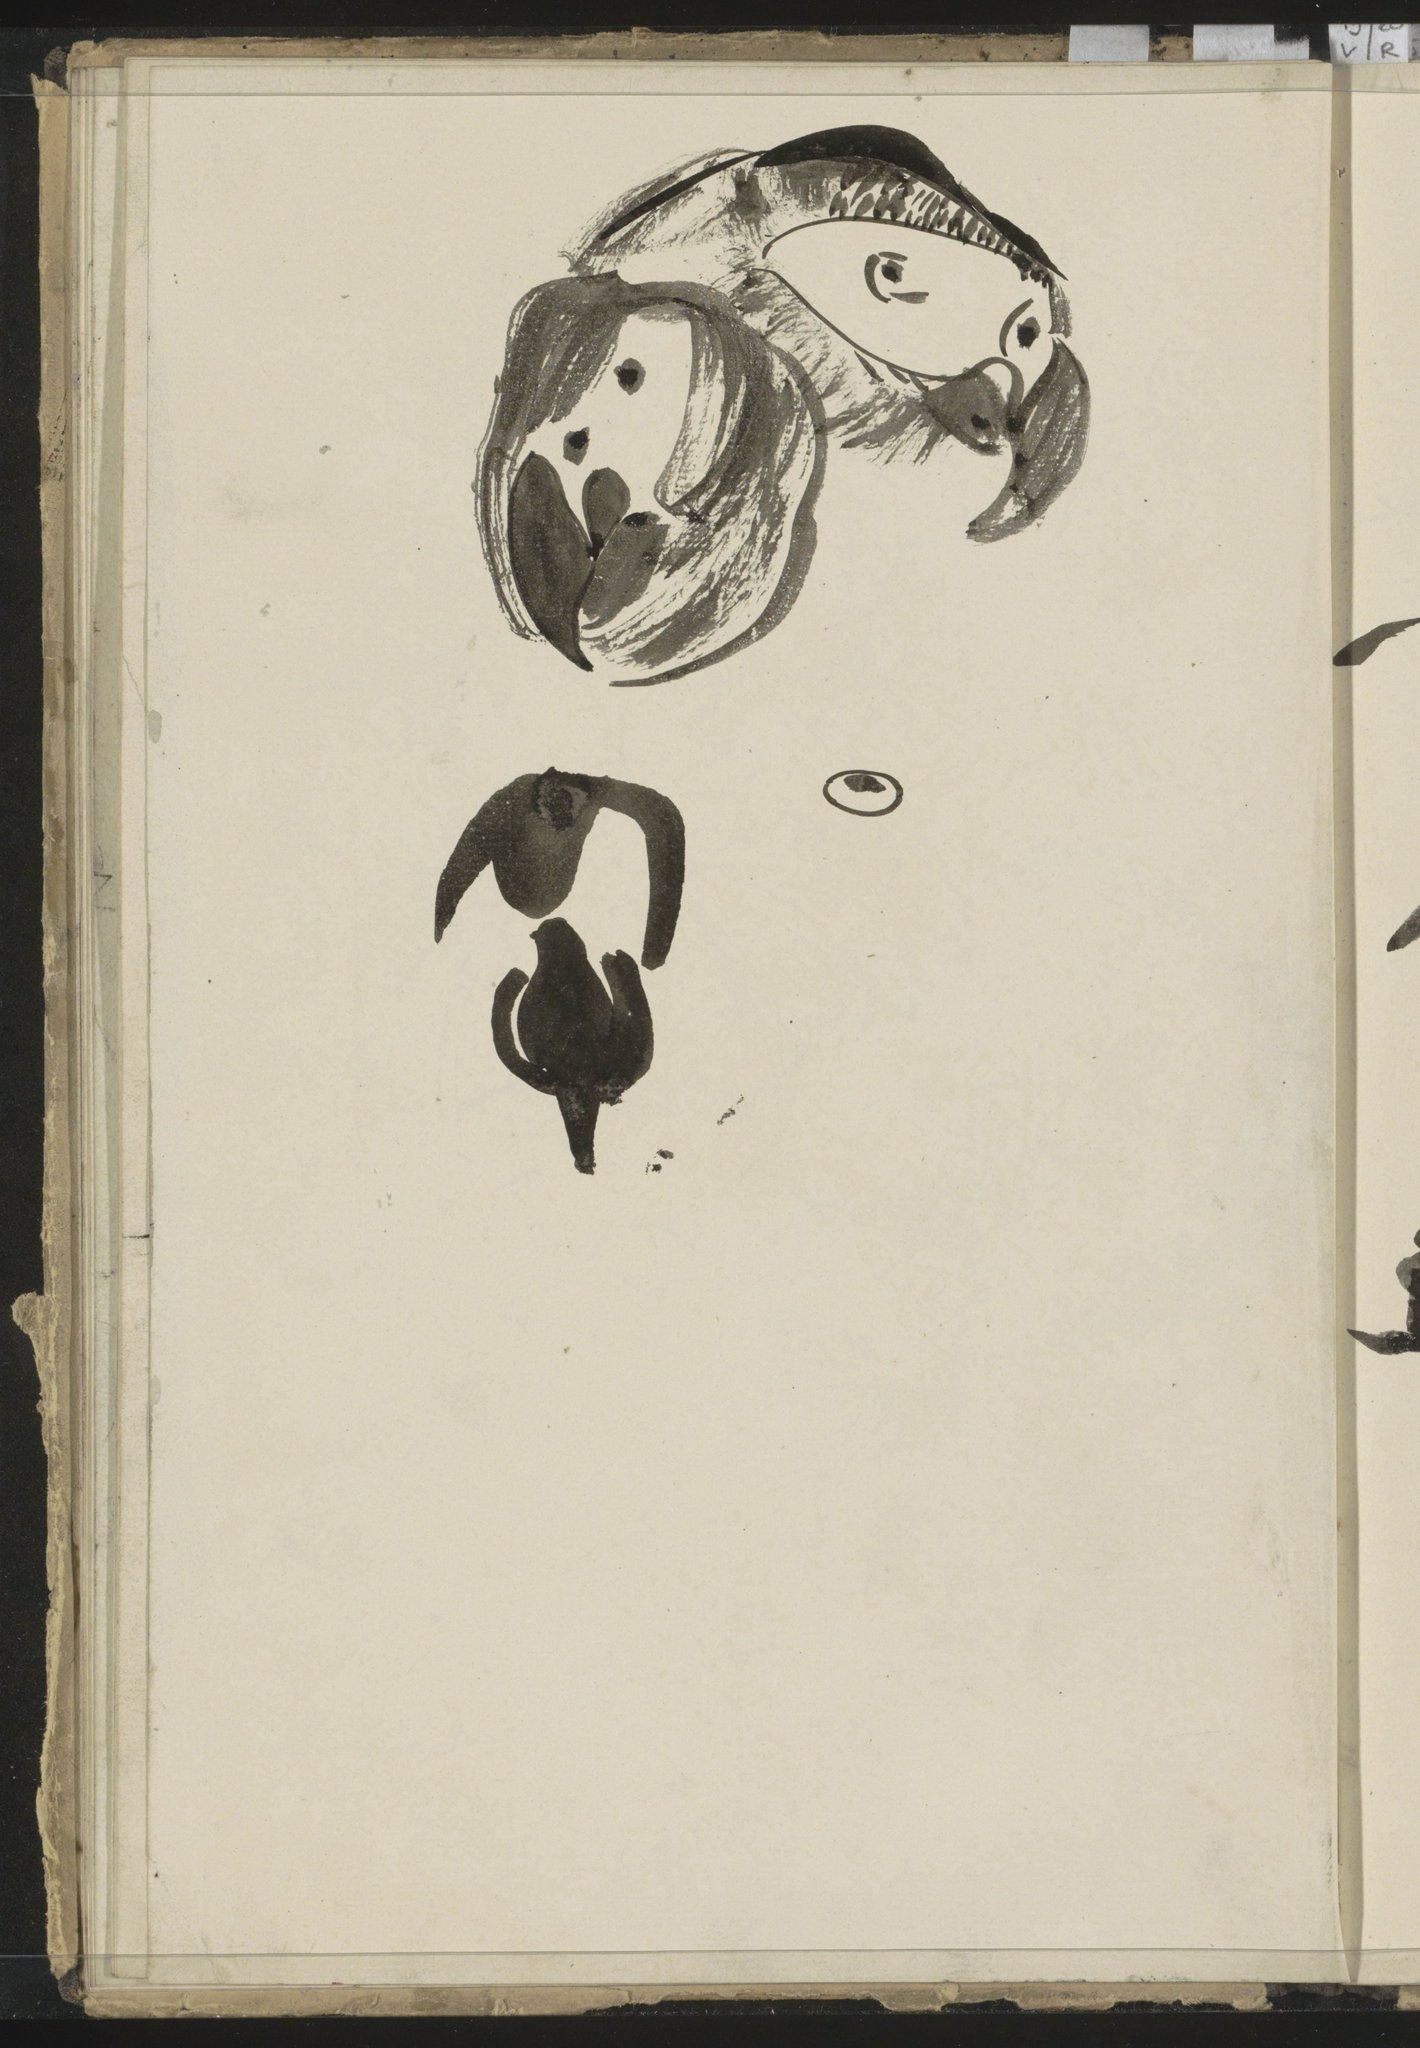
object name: sketchbook leaf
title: Kop van een papegaai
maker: carel adolph lion cachet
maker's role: draughtsman, print maker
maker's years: 1864-1945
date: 1890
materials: ink, paper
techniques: brush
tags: ornamental birds: parrot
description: Blad 17 verso uit een schetsboek met 38 bladen.